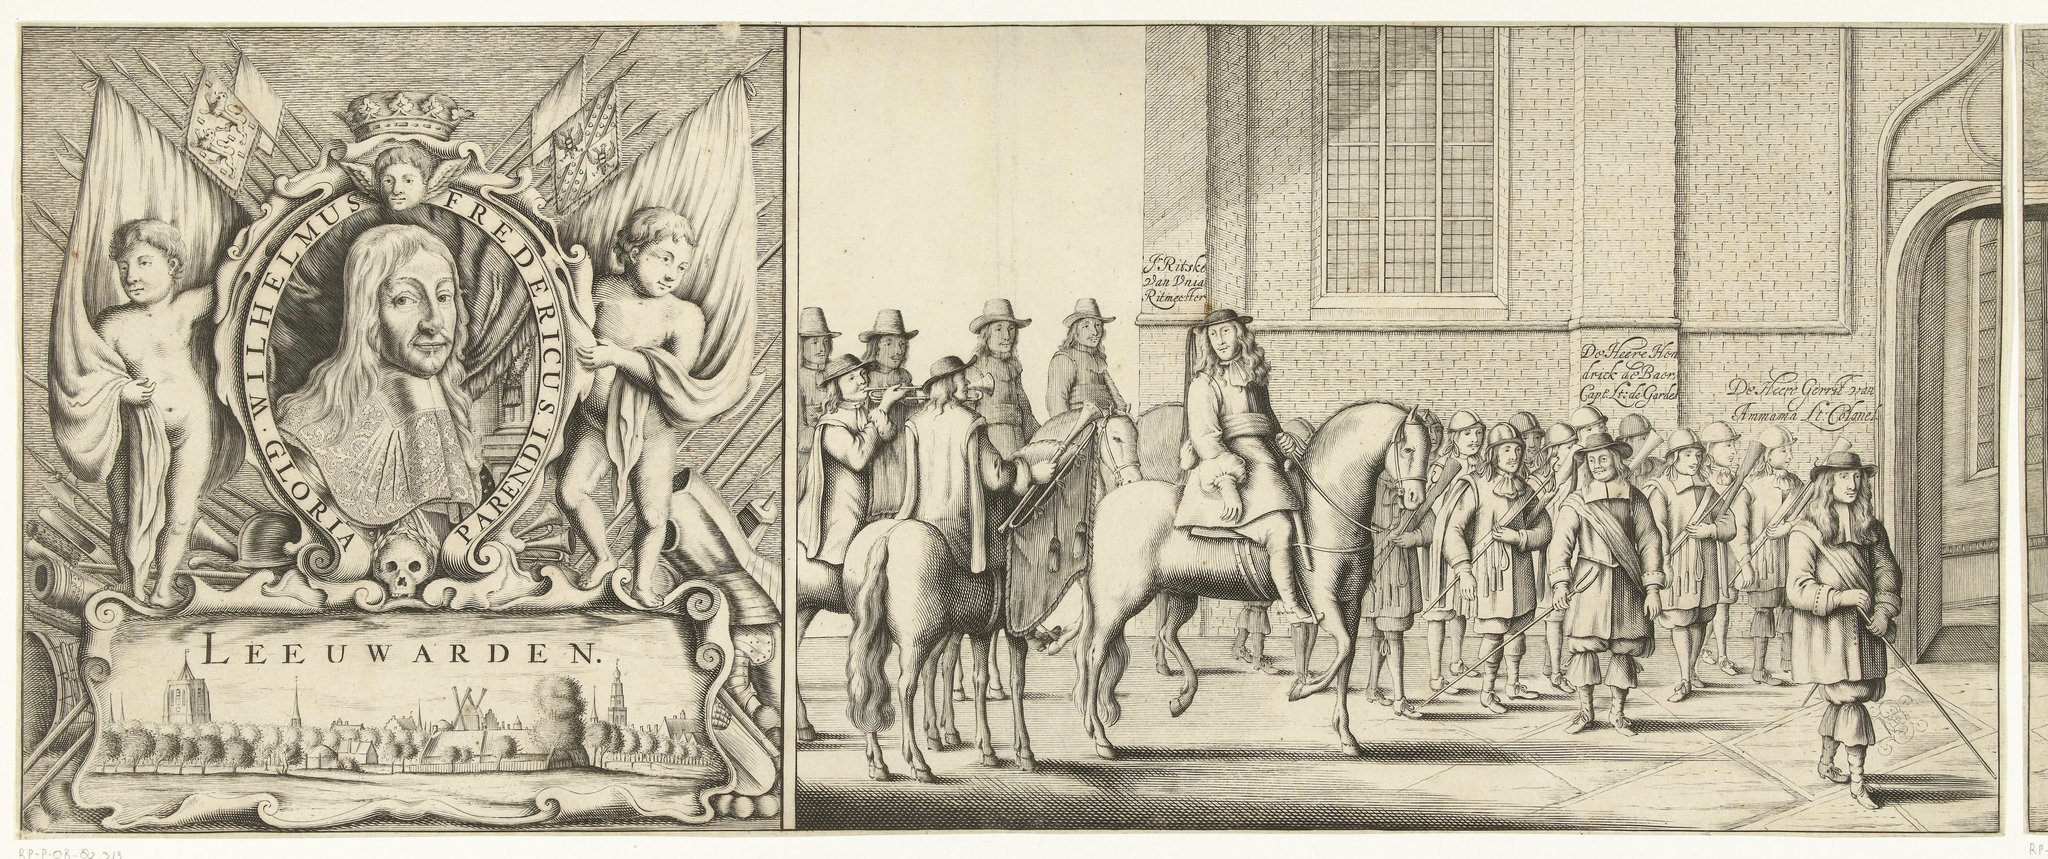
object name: print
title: Begrafenisoptocht van Willem Frederik, graaf van Nassau-Dietz (blad 1), 1665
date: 1666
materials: paper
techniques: engraving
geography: leeuwarden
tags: arnhem, cortege, funeral procession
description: Begrafenisoptocht van Willem Frederik, graaf van Nassau-Dietz, in Leeuwarden op 6 januari 1665. Portret van Willem Frederik in een cartouche met twee engelen en versierd met vaandels. Onder het portret een kleine profiel van Leeuwarden. Rechts soldaten en ruiters bij de ingang van de Jacobijnerkerk. Plaat nr. 1 in een ensemble van 24 (van de 25) ongemonteerde genummerde platen (zonder tekstbladen) die samen een lange fries vormen.